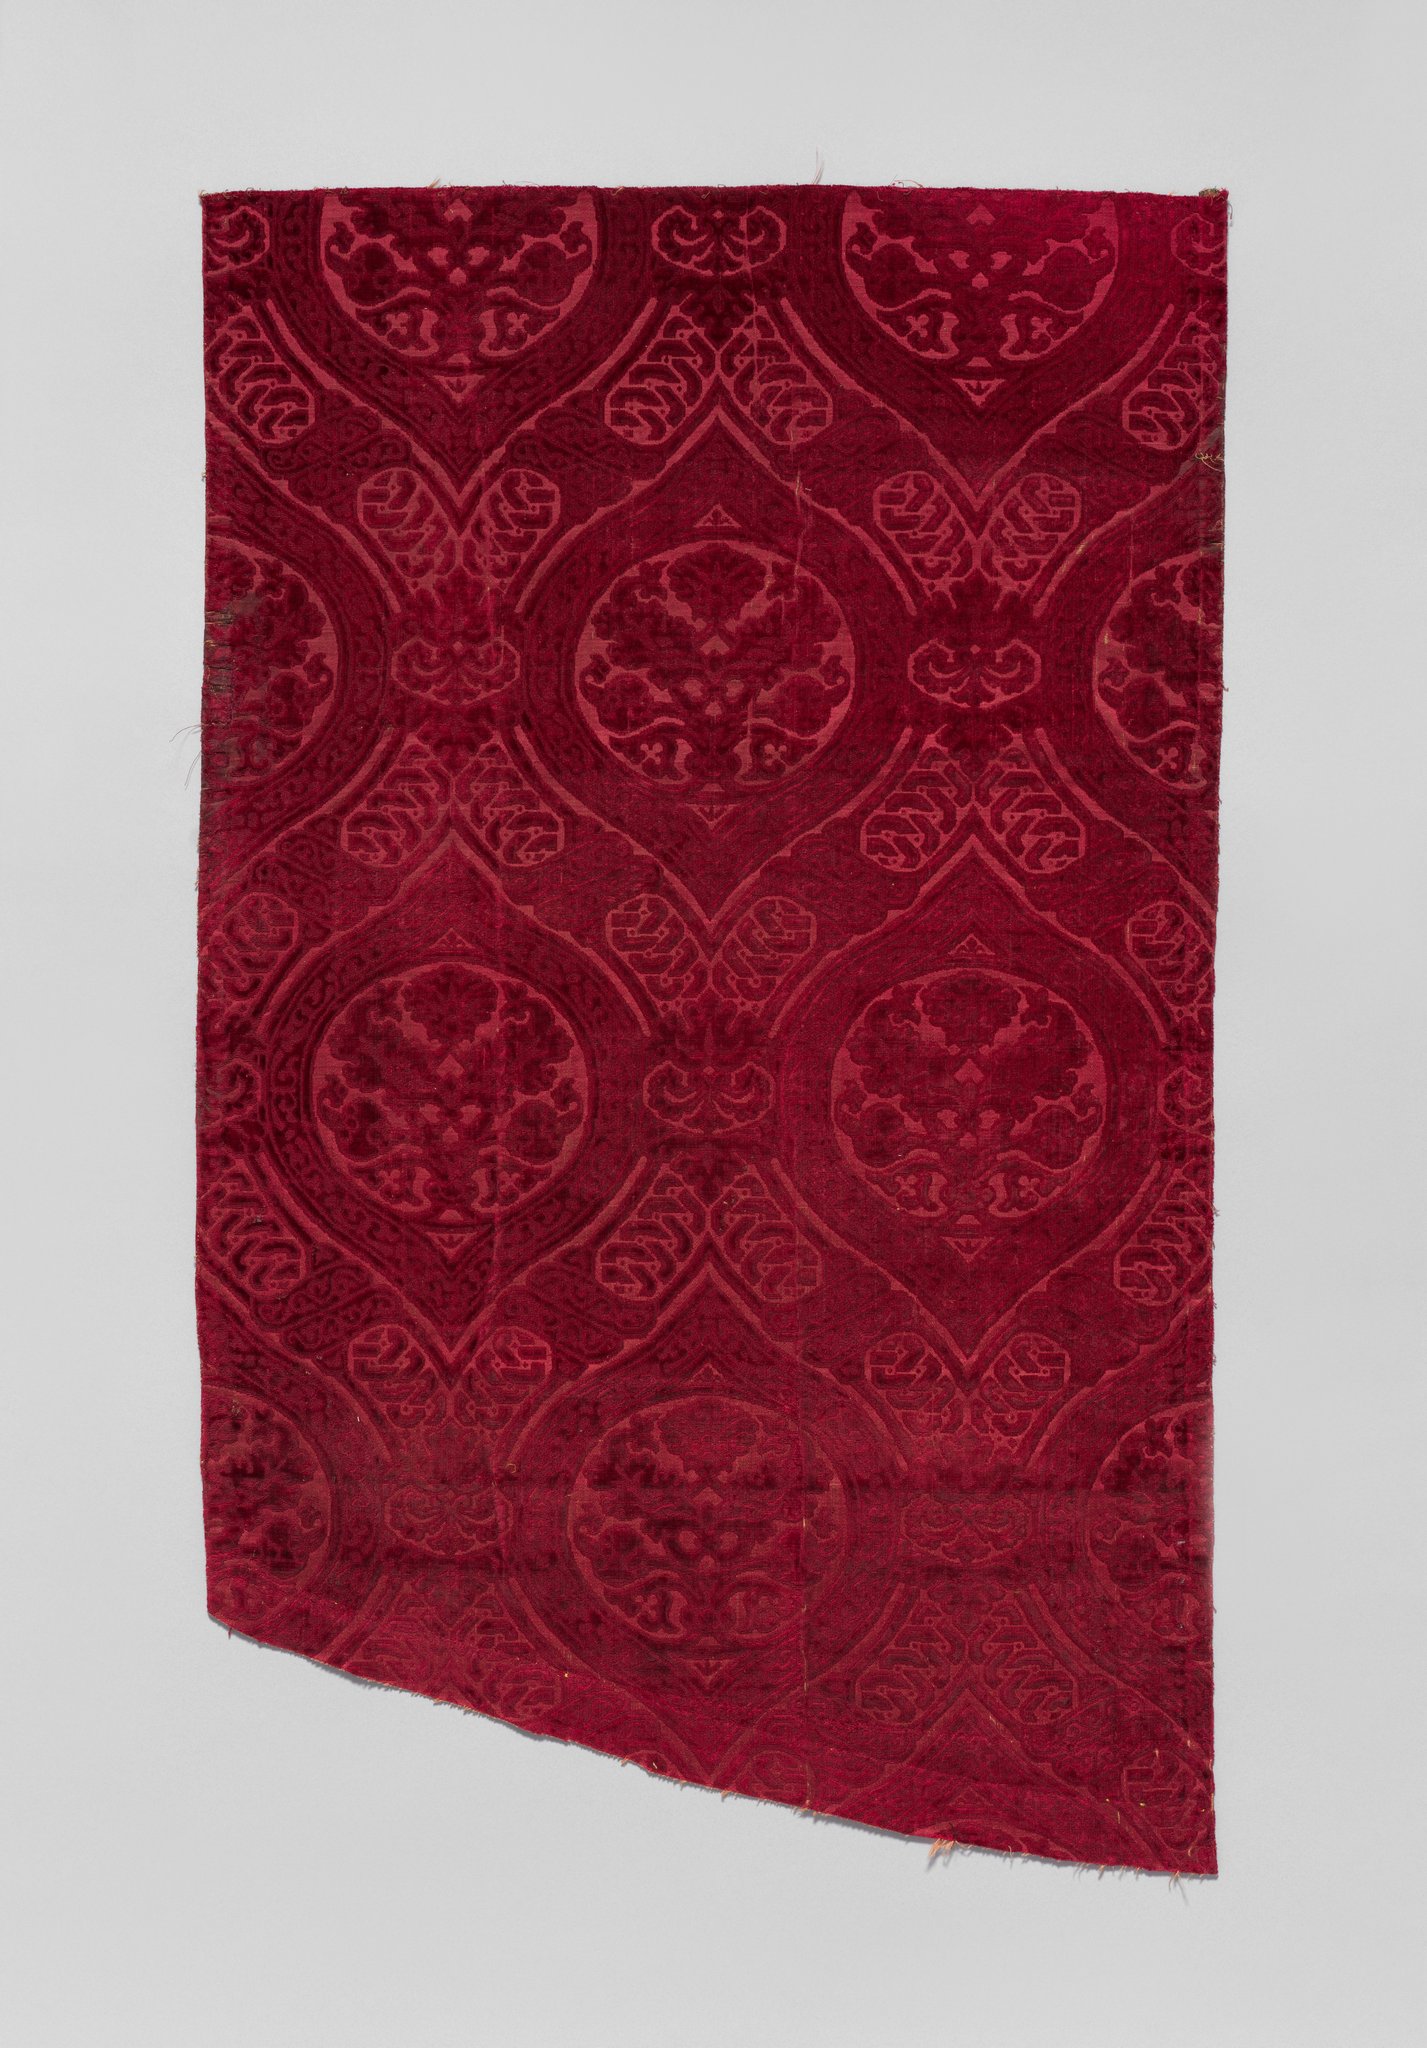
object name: piece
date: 1501-1600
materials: silk